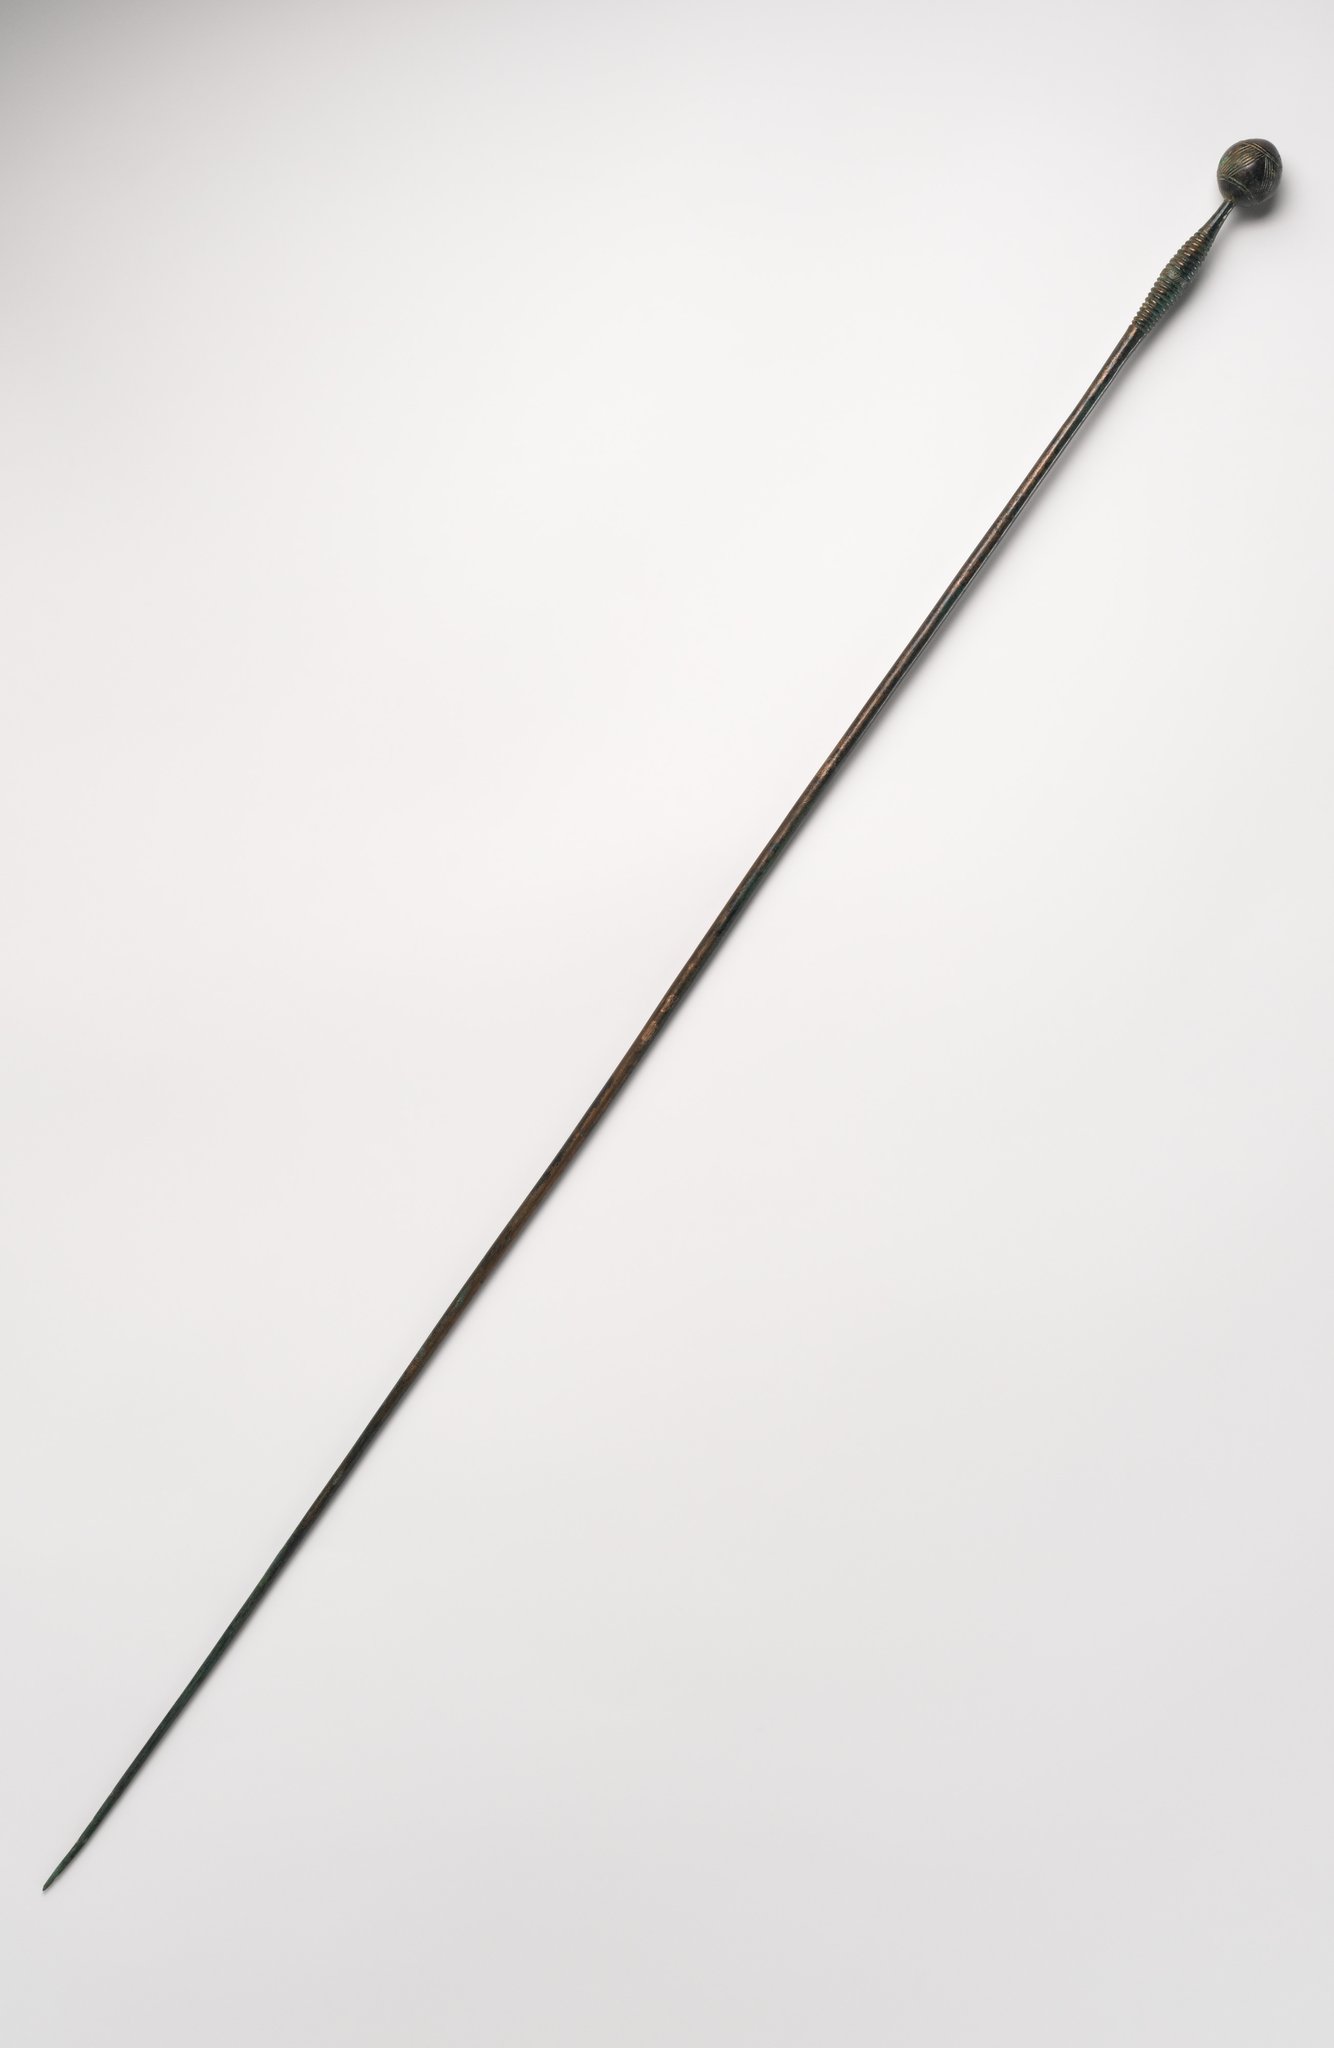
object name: pin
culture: european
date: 1200-800 BCE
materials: copper alloy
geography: carpathian basin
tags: pins